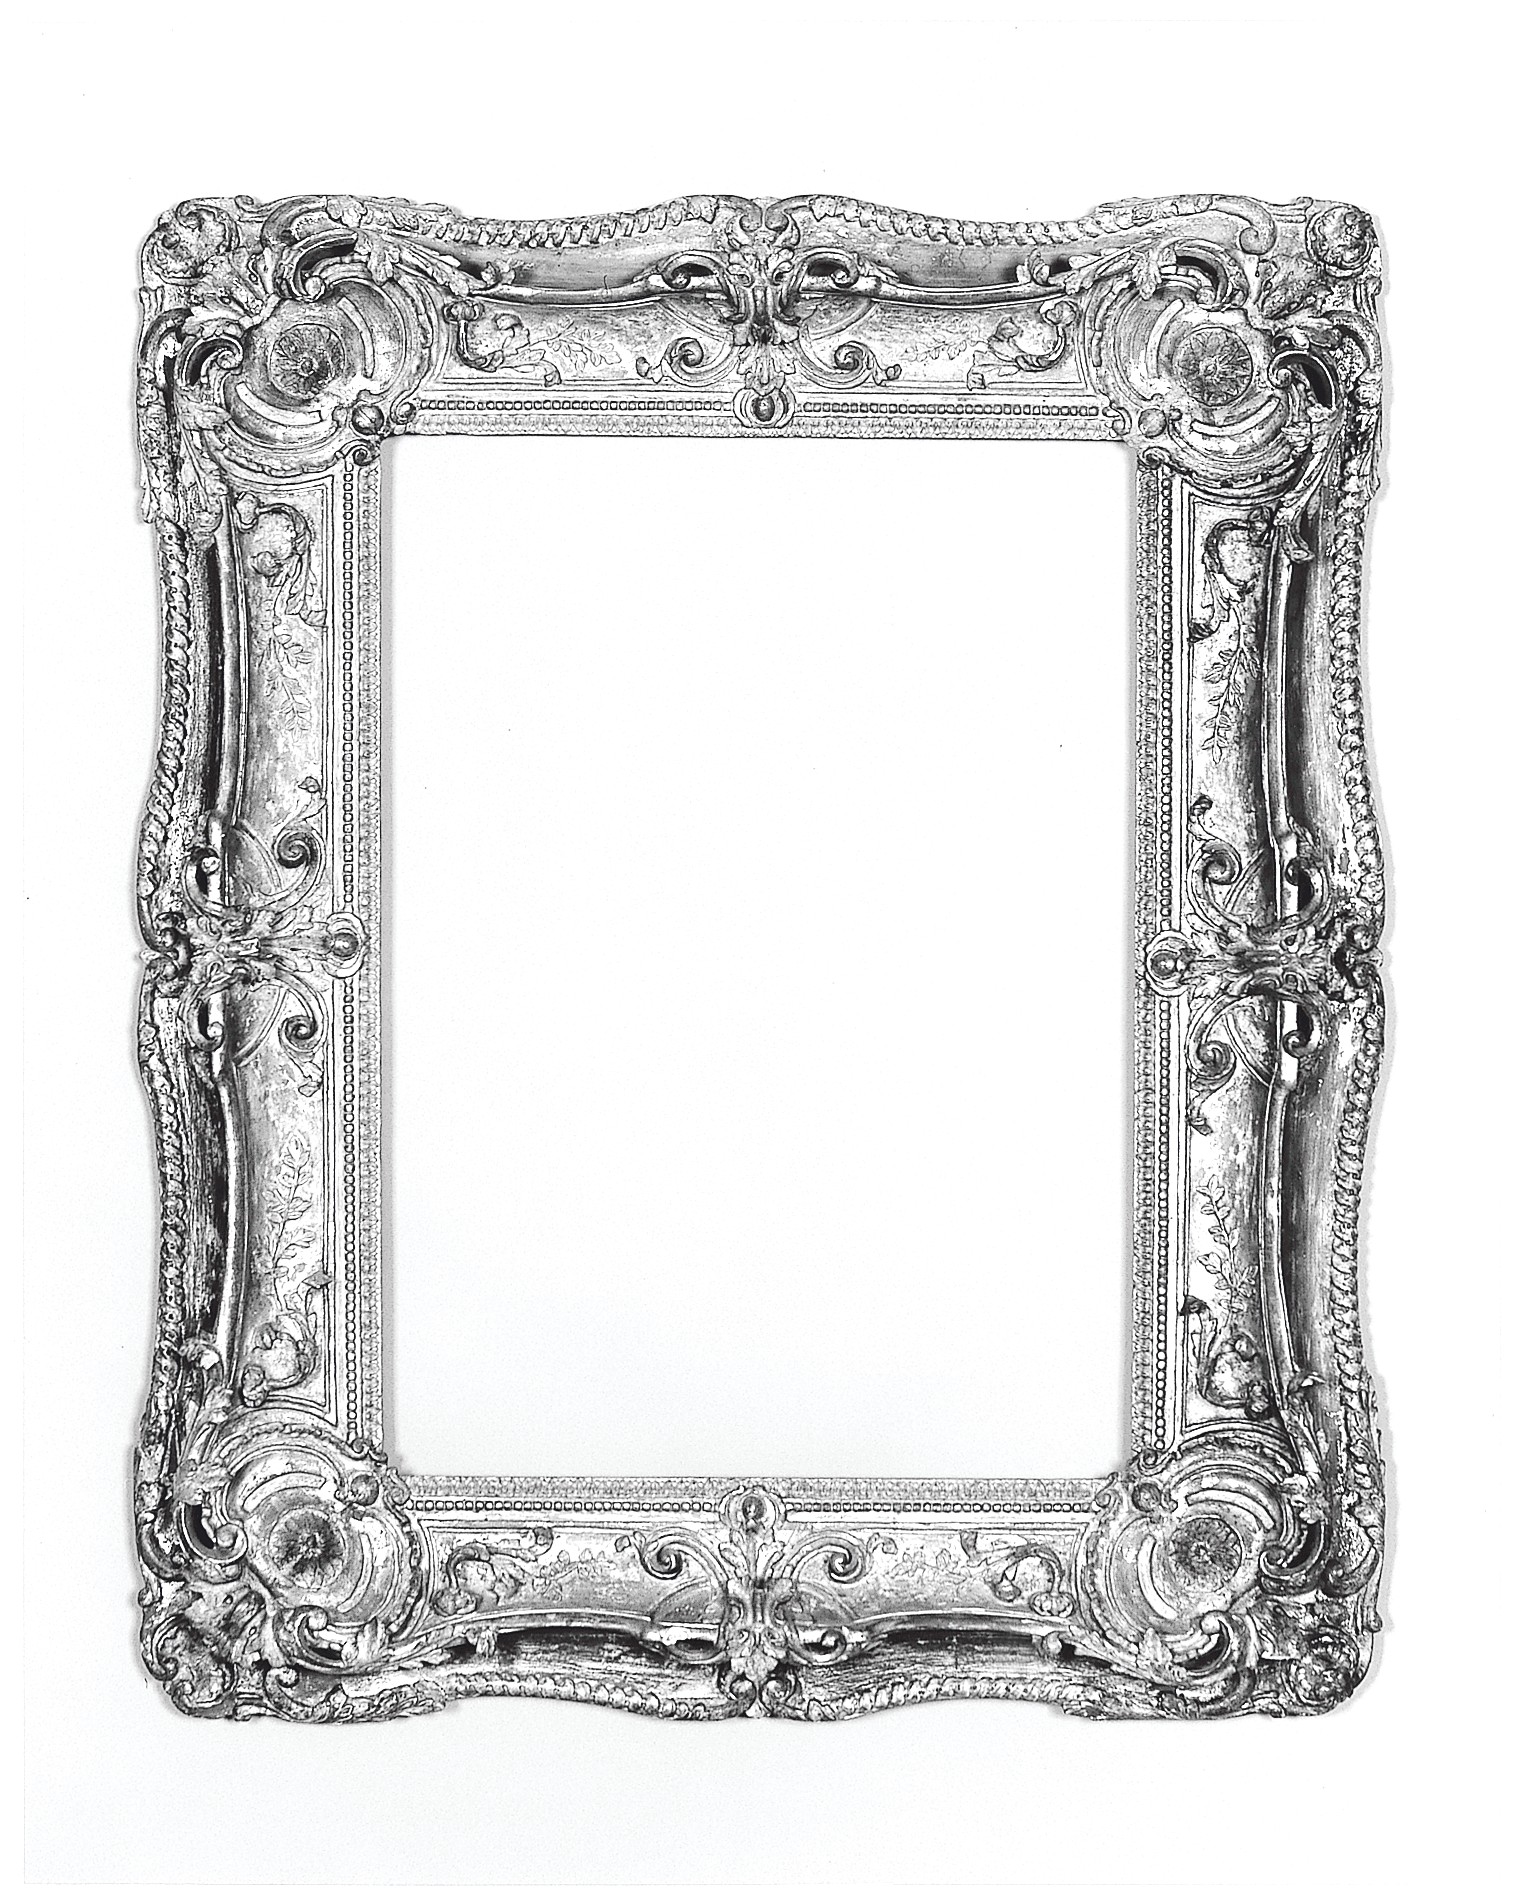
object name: frame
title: Swept frame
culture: french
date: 1750-1760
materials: feather, wood